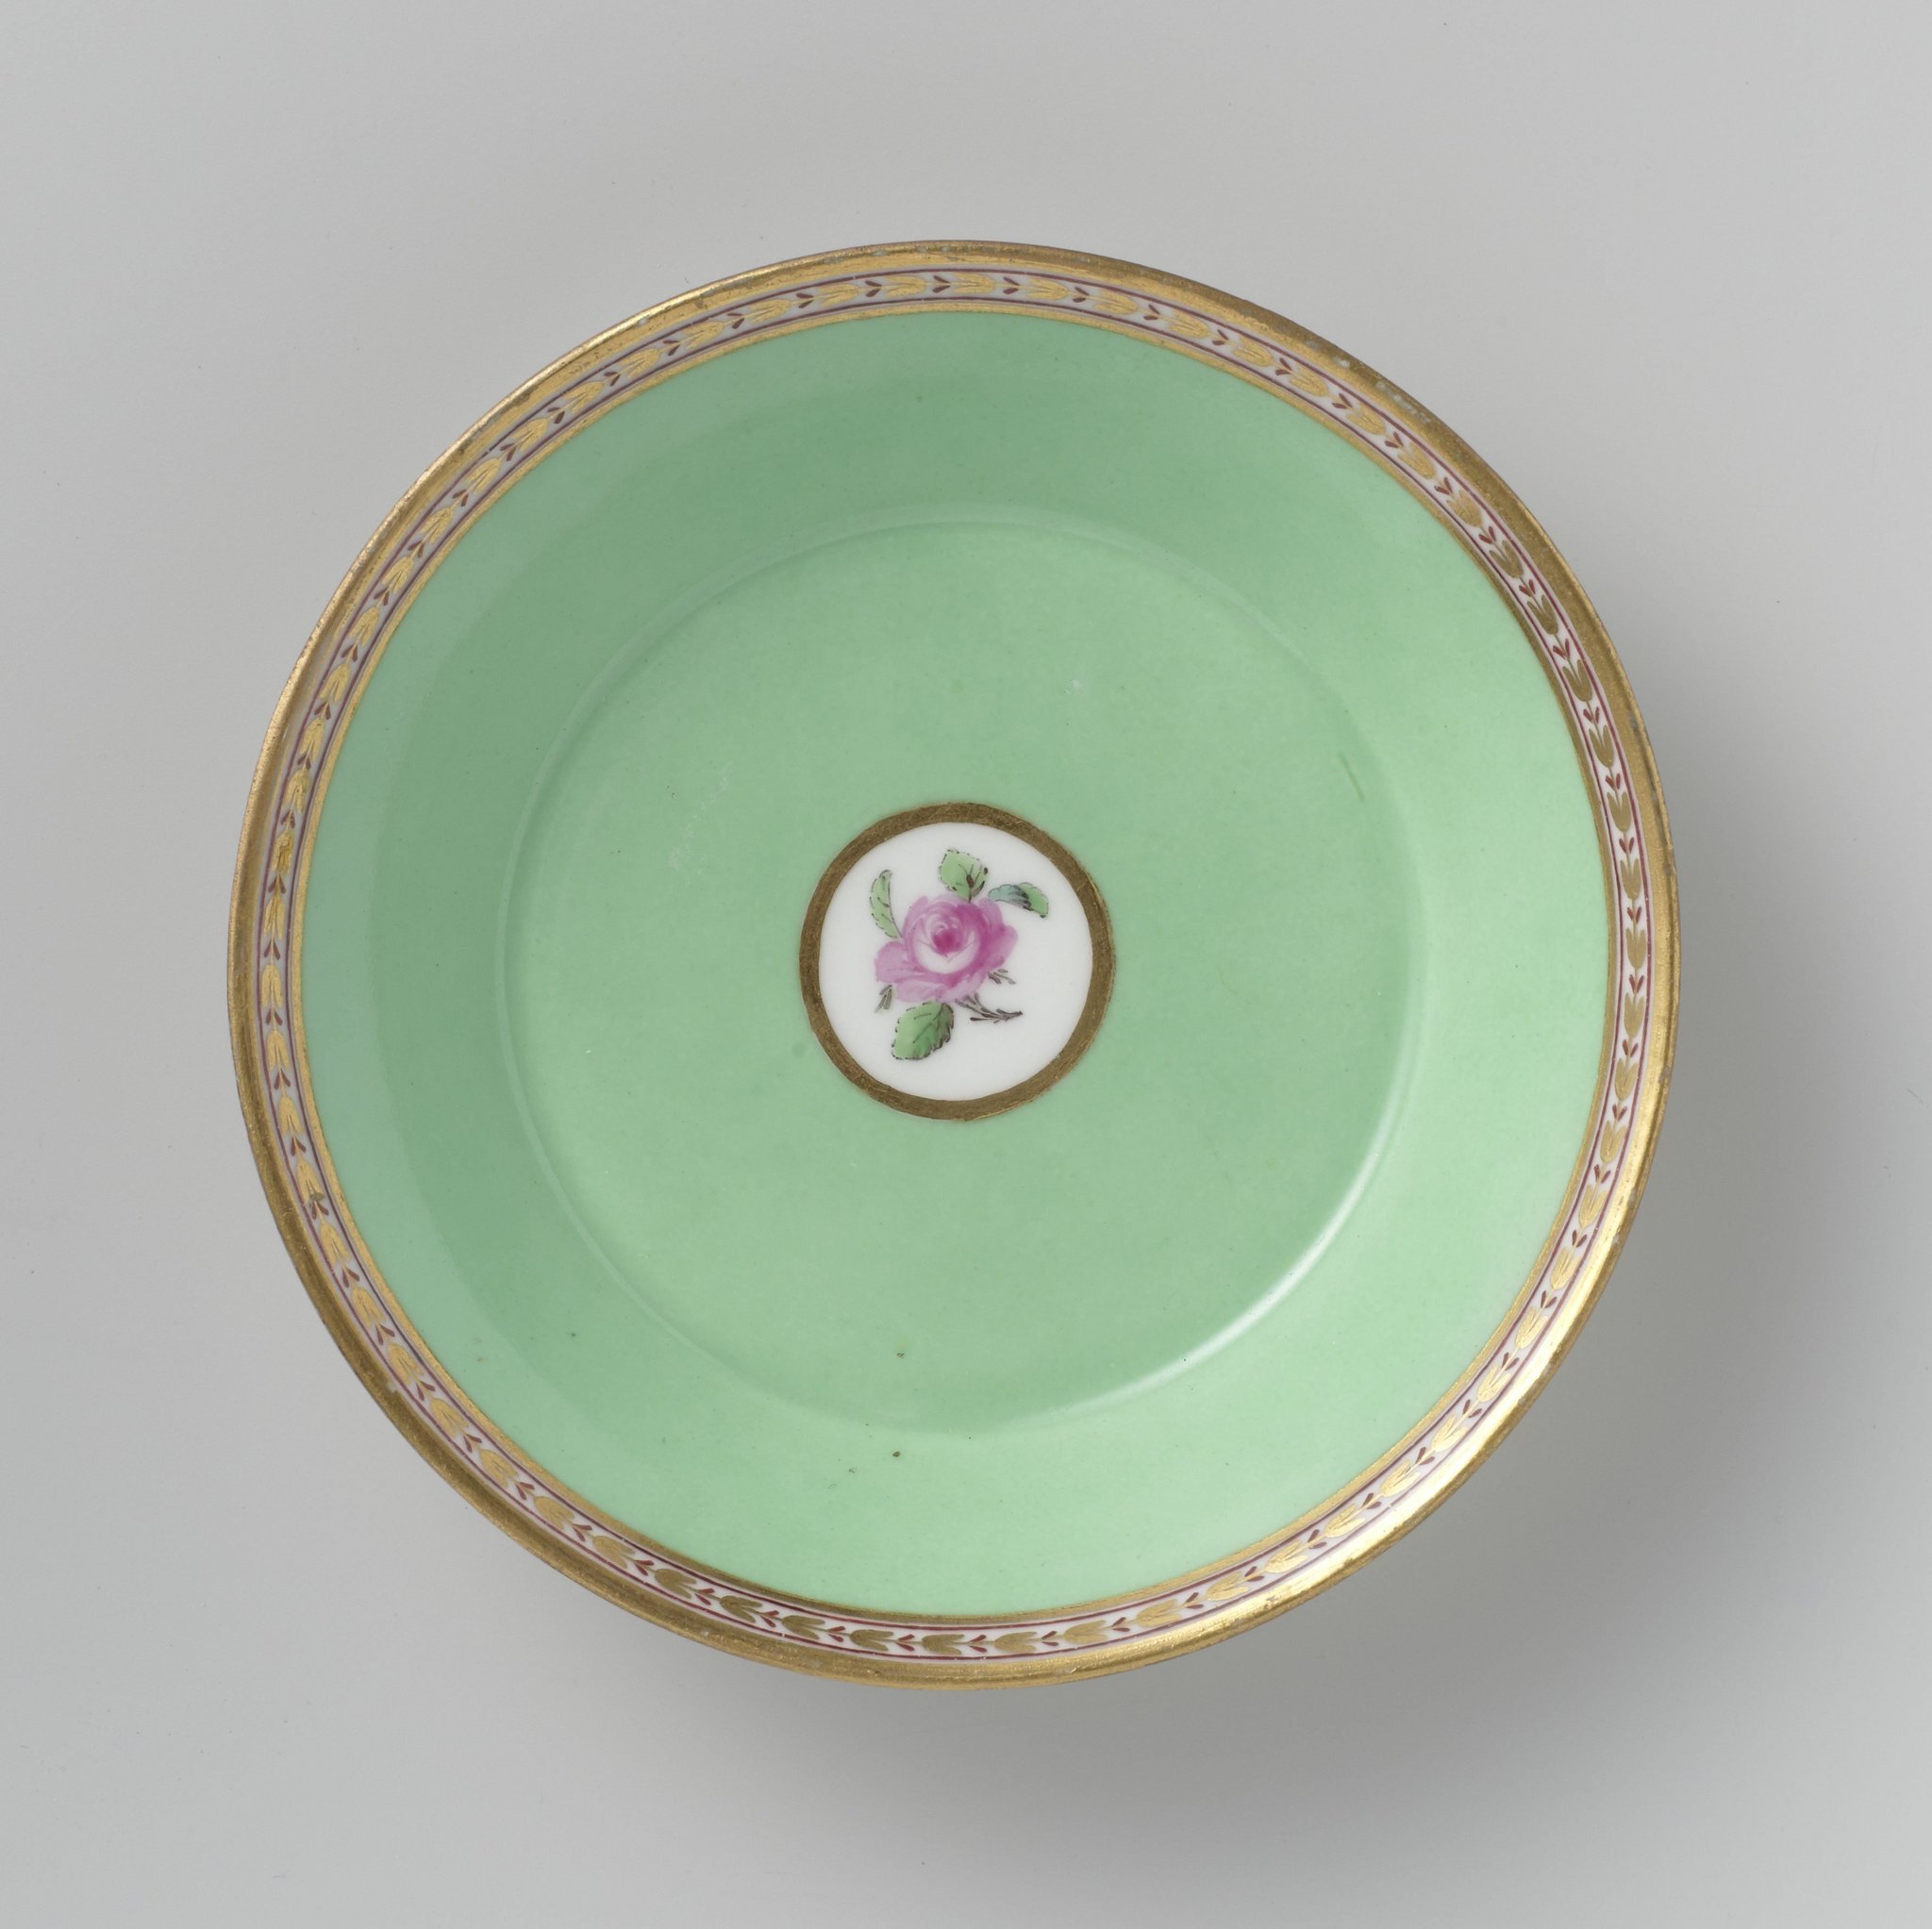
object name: platter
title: Saucer with roses in a basket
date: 1795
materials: glaze, gold, porcelain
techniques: firing, forming, gilding, turning, vitrification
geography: berlin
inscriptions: mark: ‘scepter/ 44/ II’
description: Parts of a tea and coffee service. Porcelain. Berlin, c. 1790 - 1800.